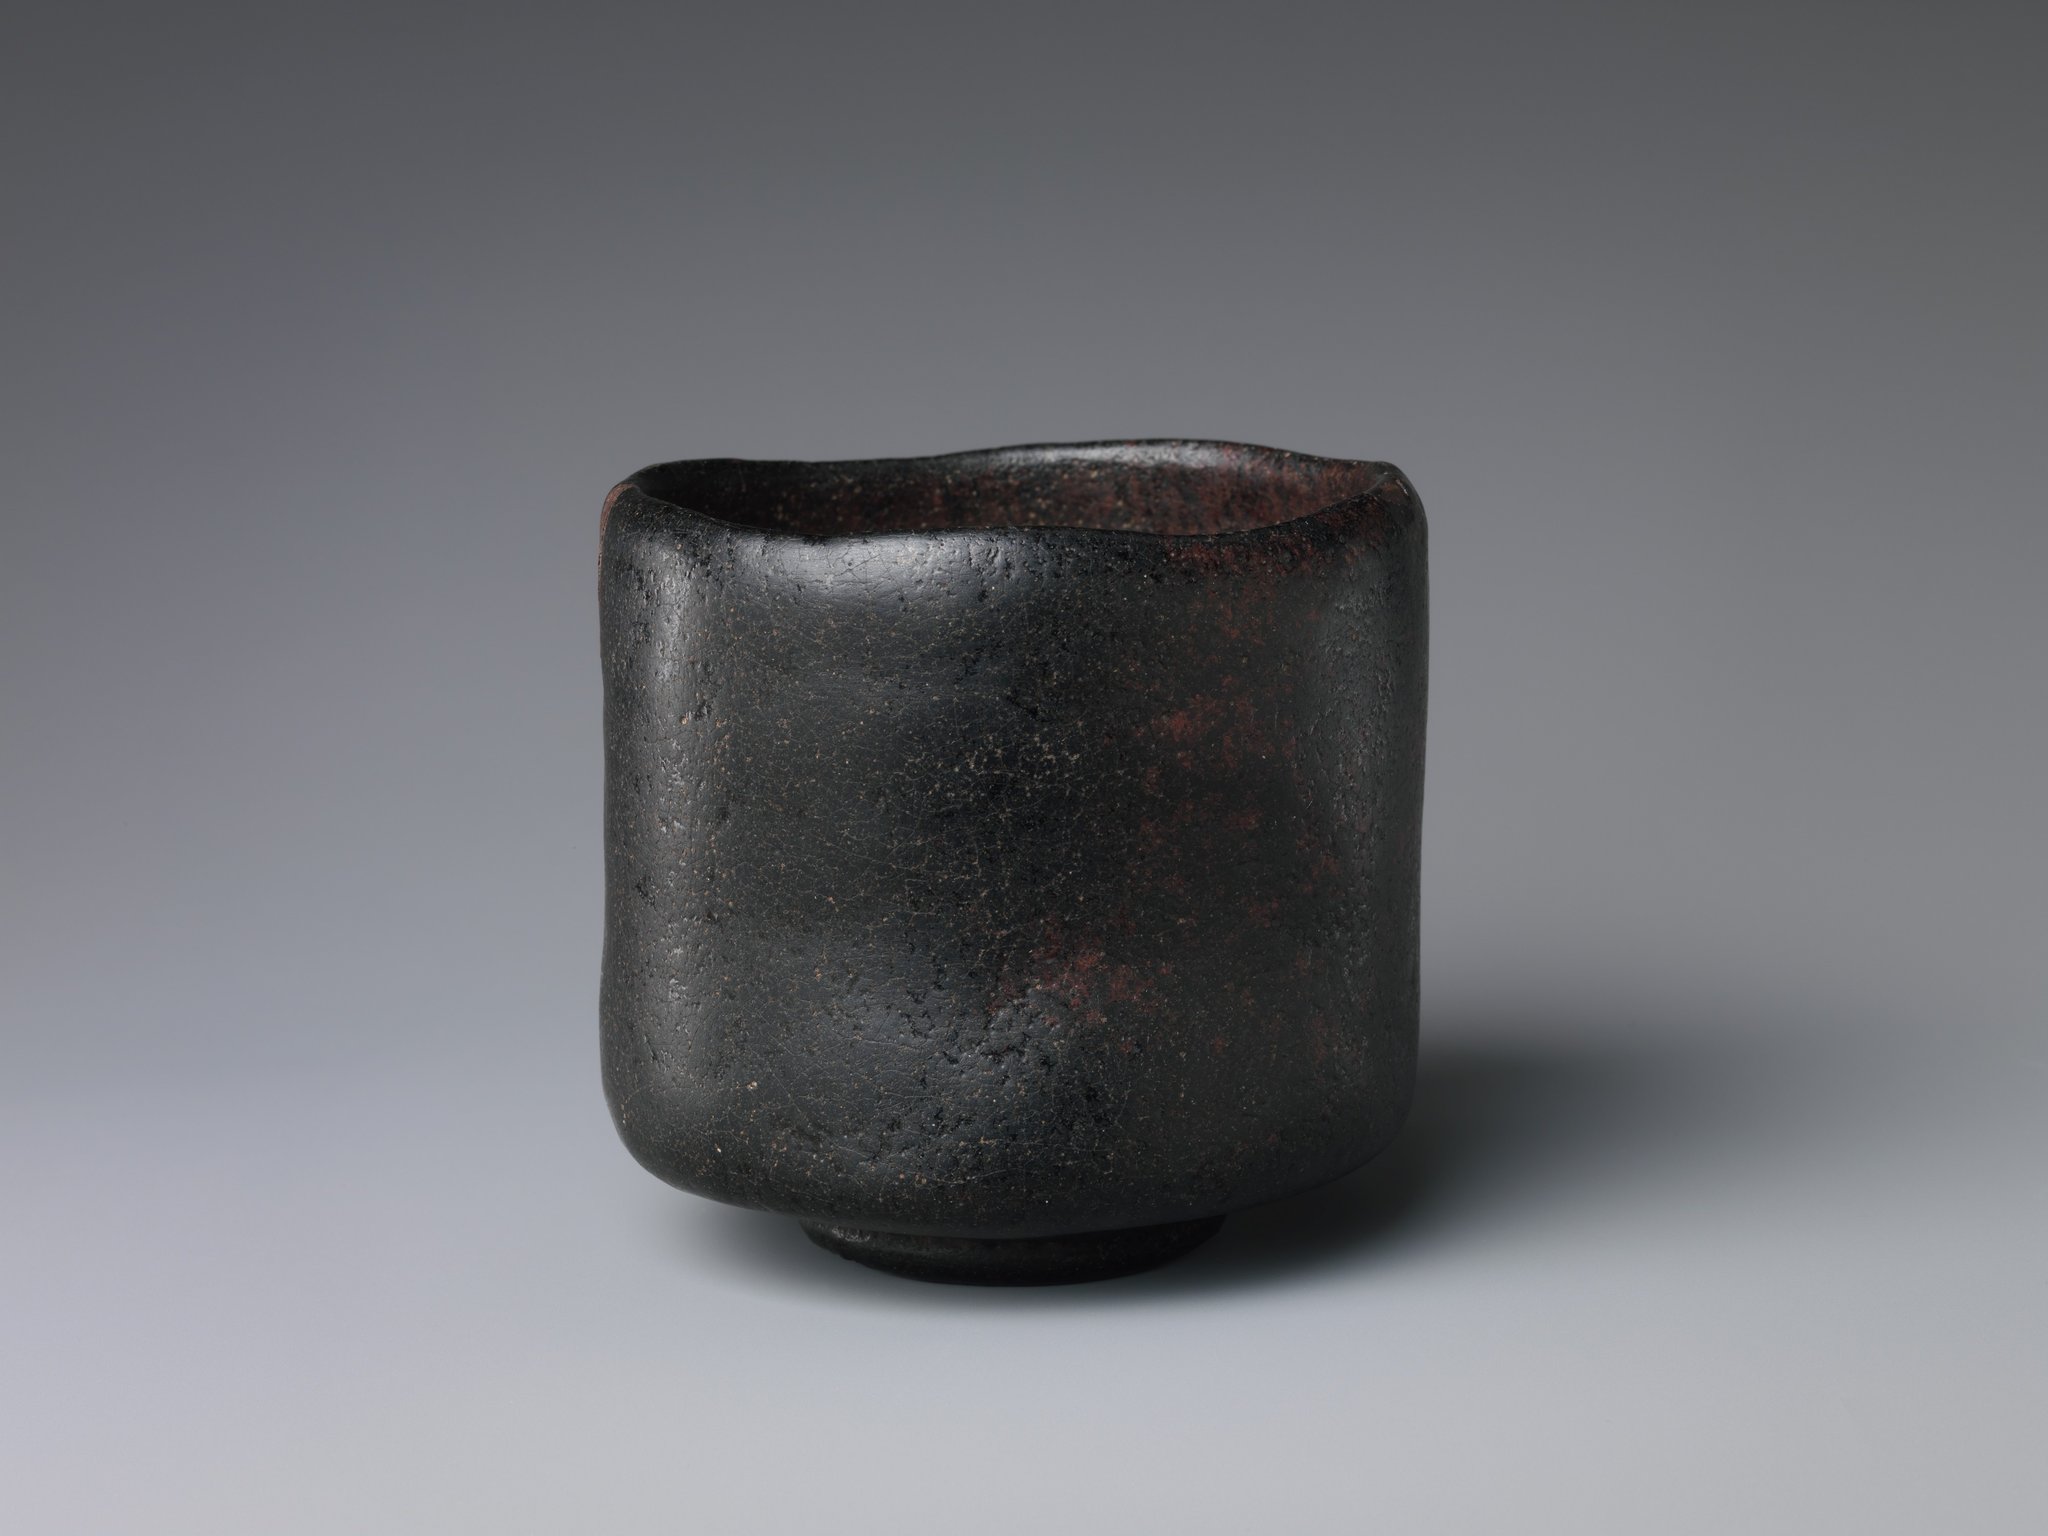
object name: tea bowl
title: Black Raku Tea Bowl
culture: japanese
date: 1601-1633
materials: earthenware, glaze